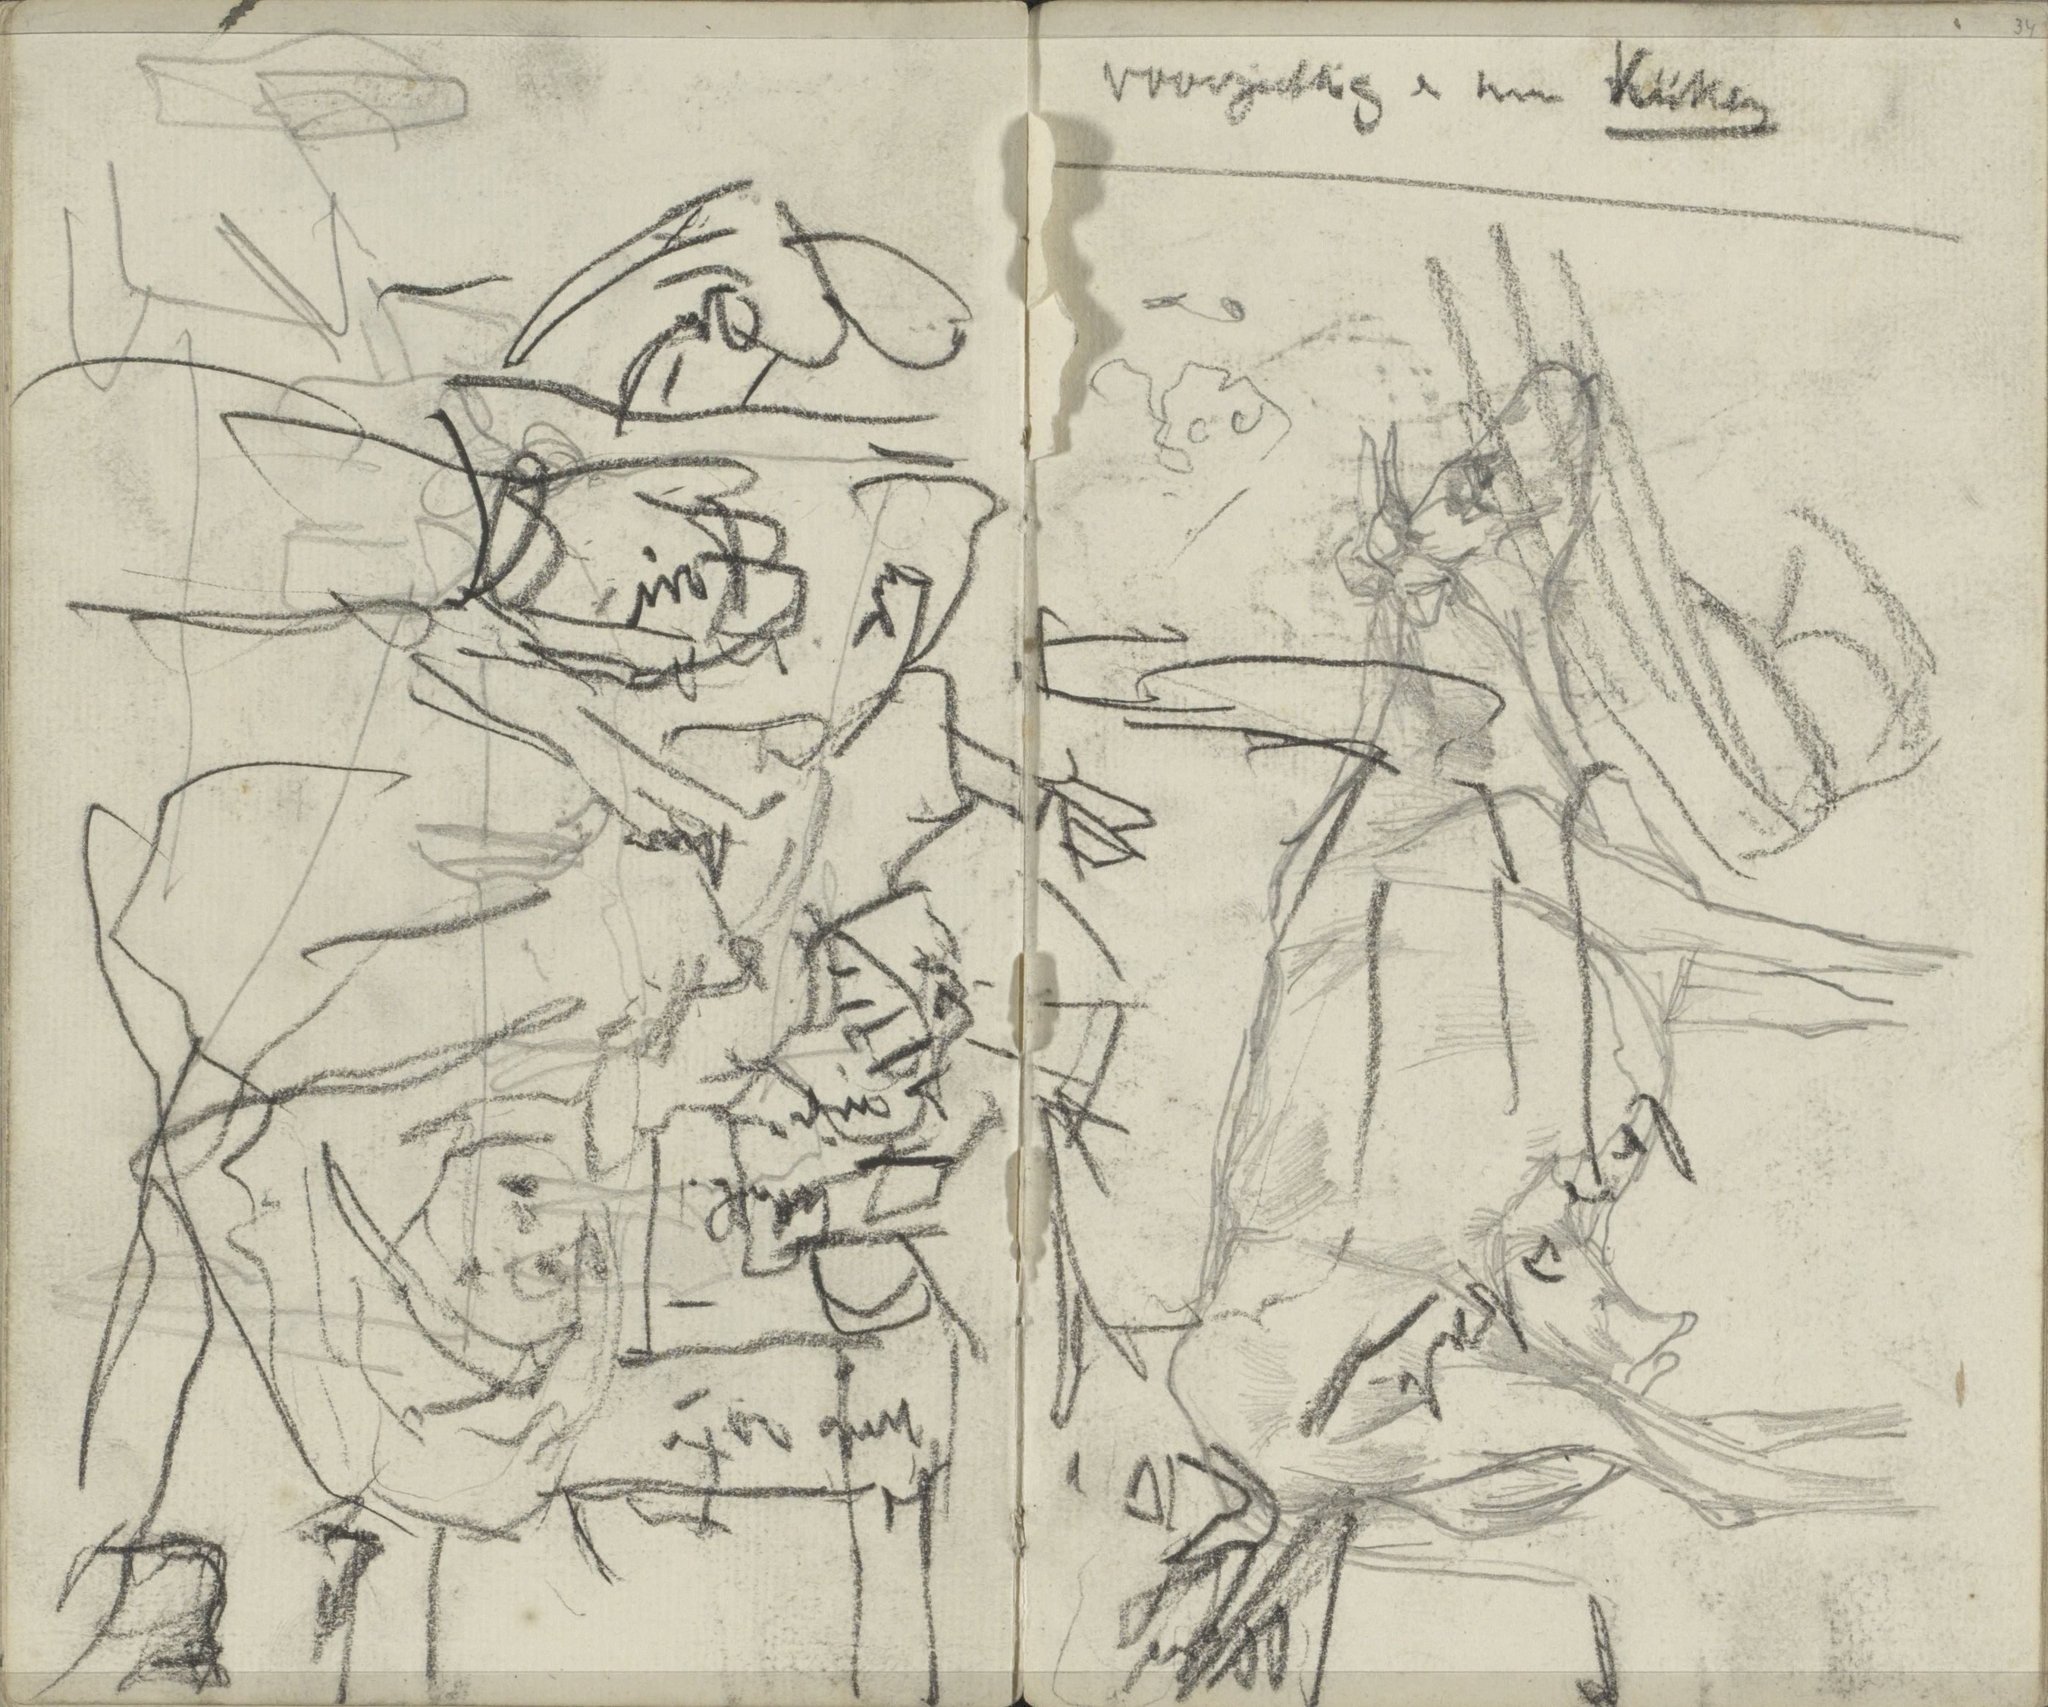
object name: sketchbook leaf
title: Studieblad met figuren en een koe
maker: george hendrik breitner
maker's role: draughtsman, painter, print maker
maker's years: 1857-1923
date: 1887-1889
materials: chalk, paper, pencil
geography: the hague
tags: cow, adult woman, child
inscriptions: annotation: ‘[...]/ voorzichtig [...] kijken’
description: Pagina 33 en pagina 34 uit een schetsboek met 27 bladen.